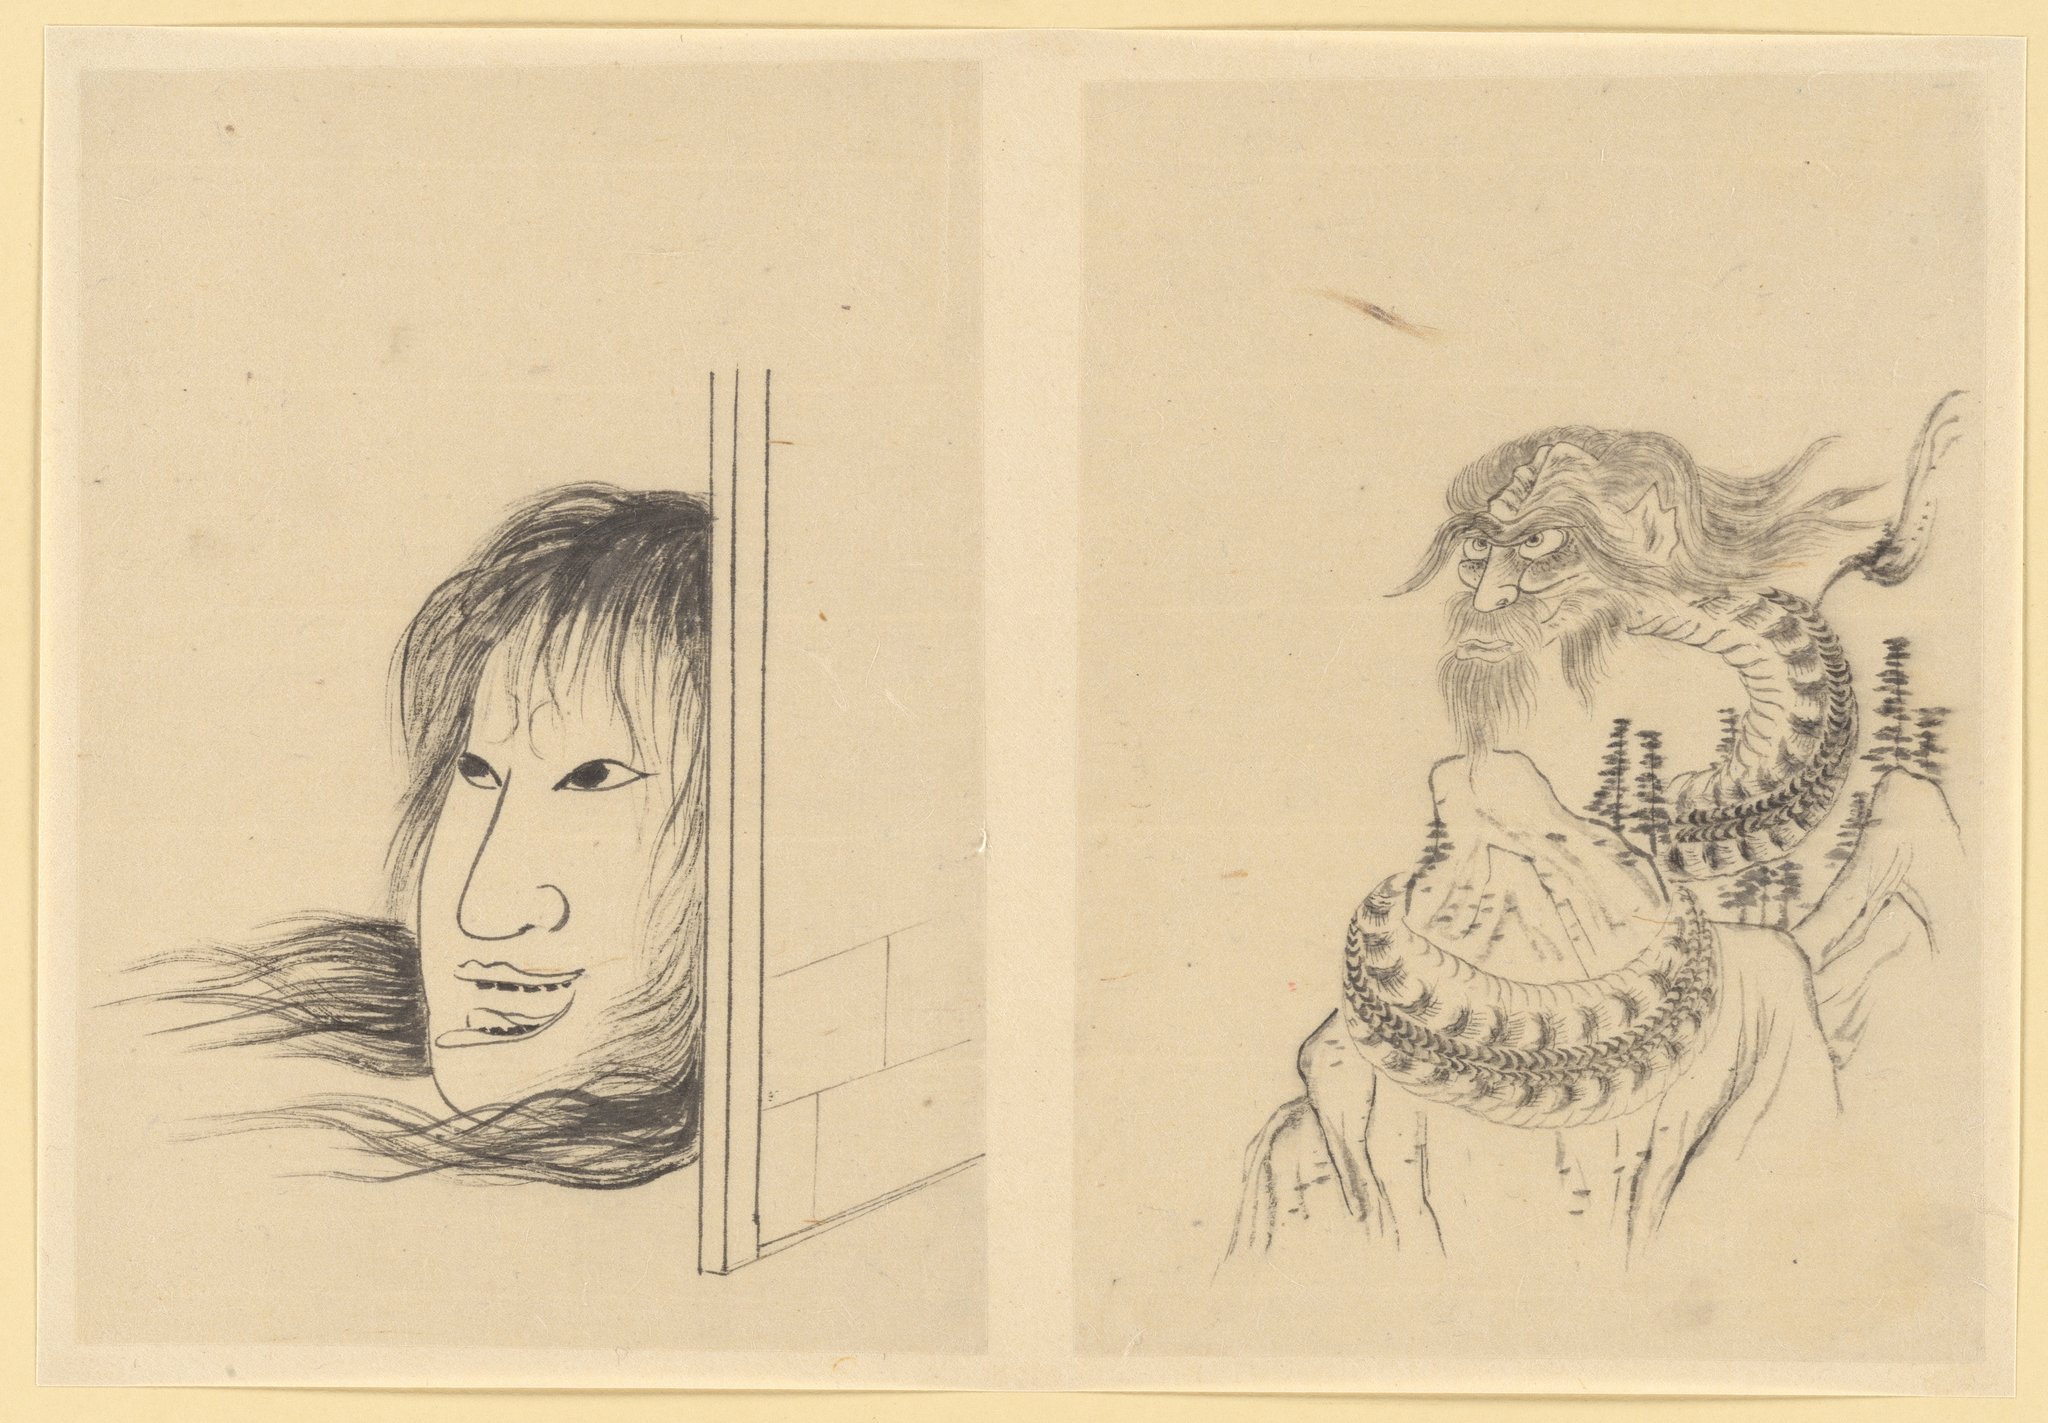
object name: painting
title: Ghosts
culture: japanese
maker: katsushika hokusai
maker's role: artist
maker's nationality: japanese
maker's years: 1760-1849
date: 1701-1900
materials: ink, paper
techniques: painting